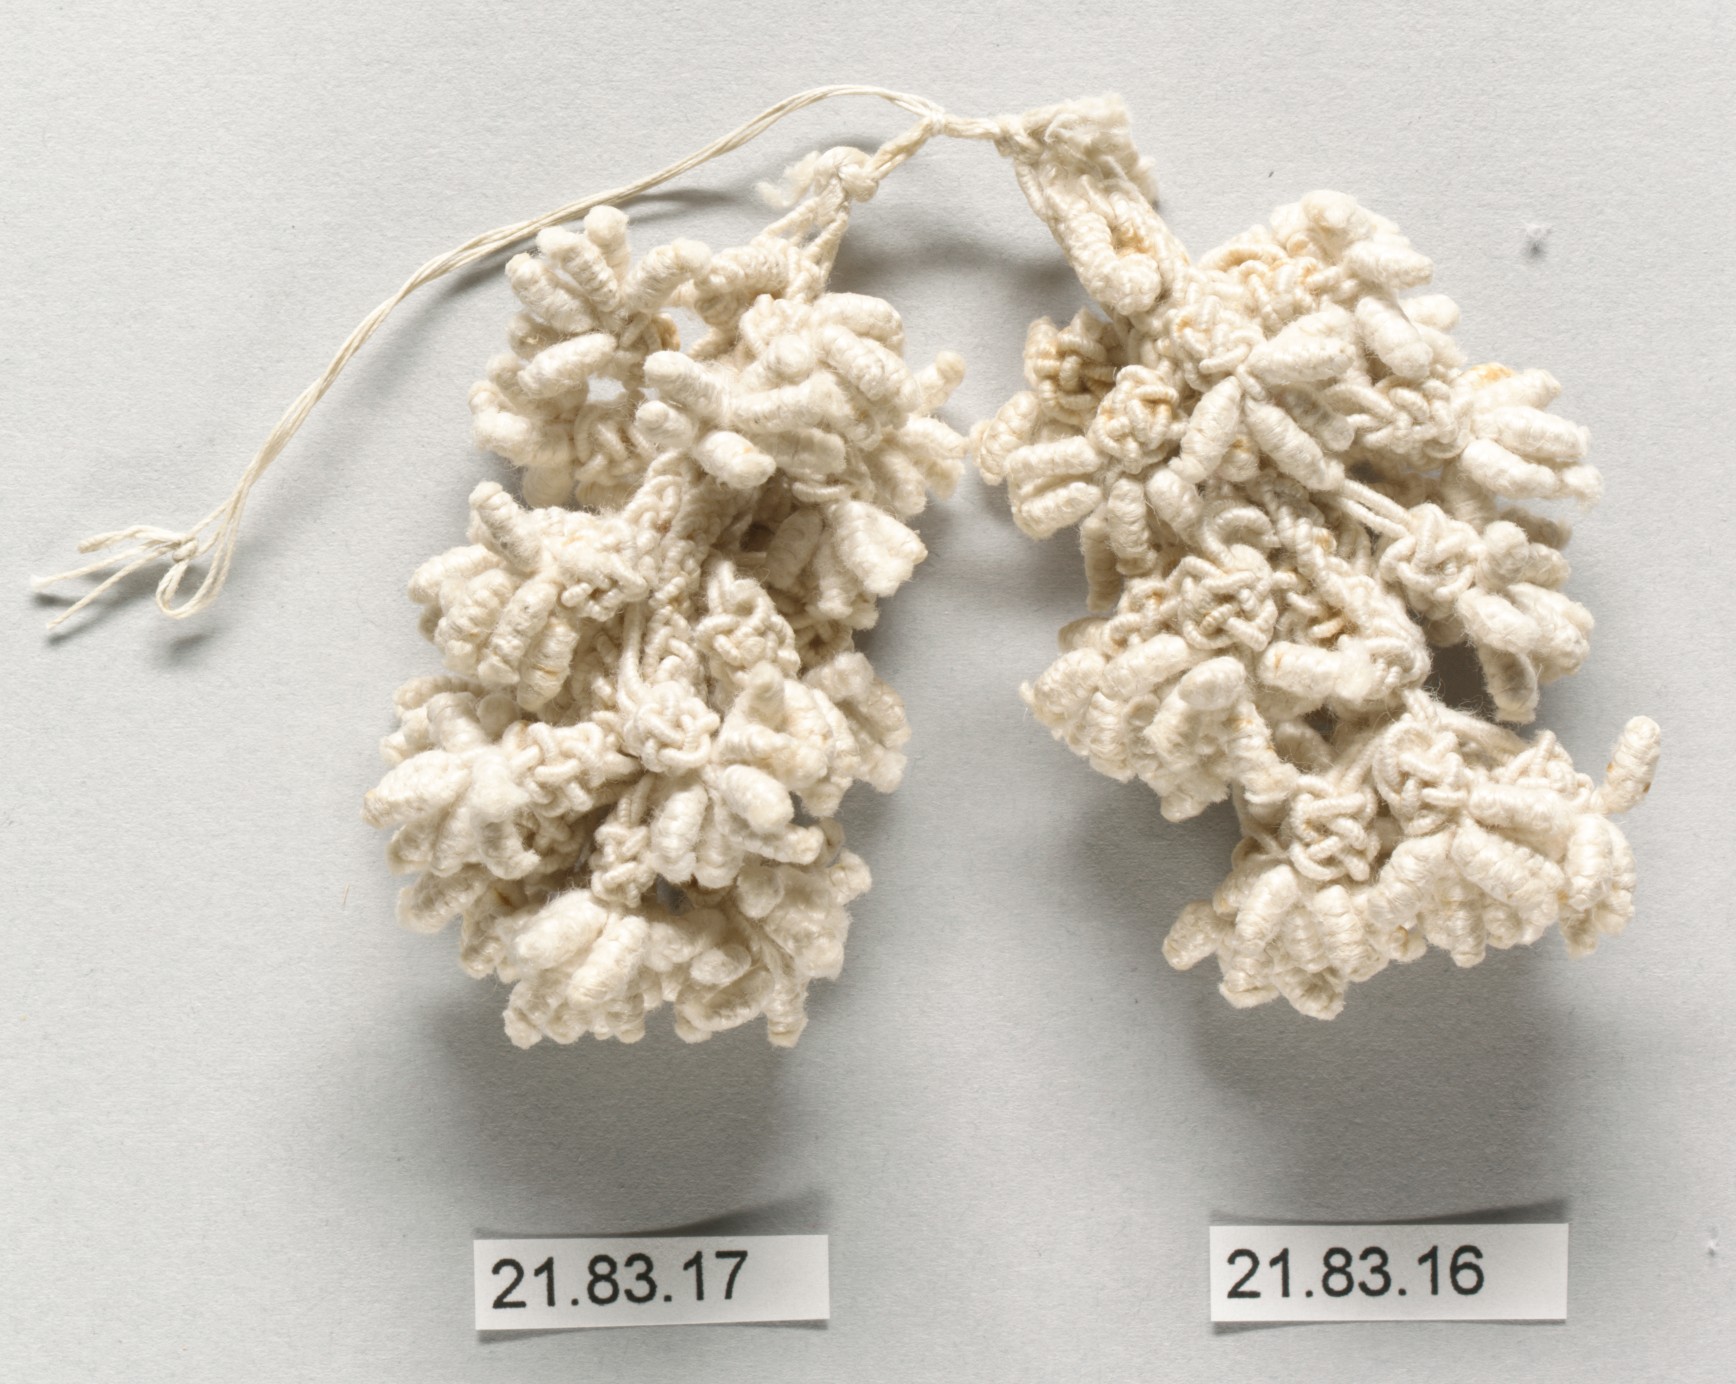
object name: tassel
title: Pair of tassels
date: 1601-1700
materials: linen